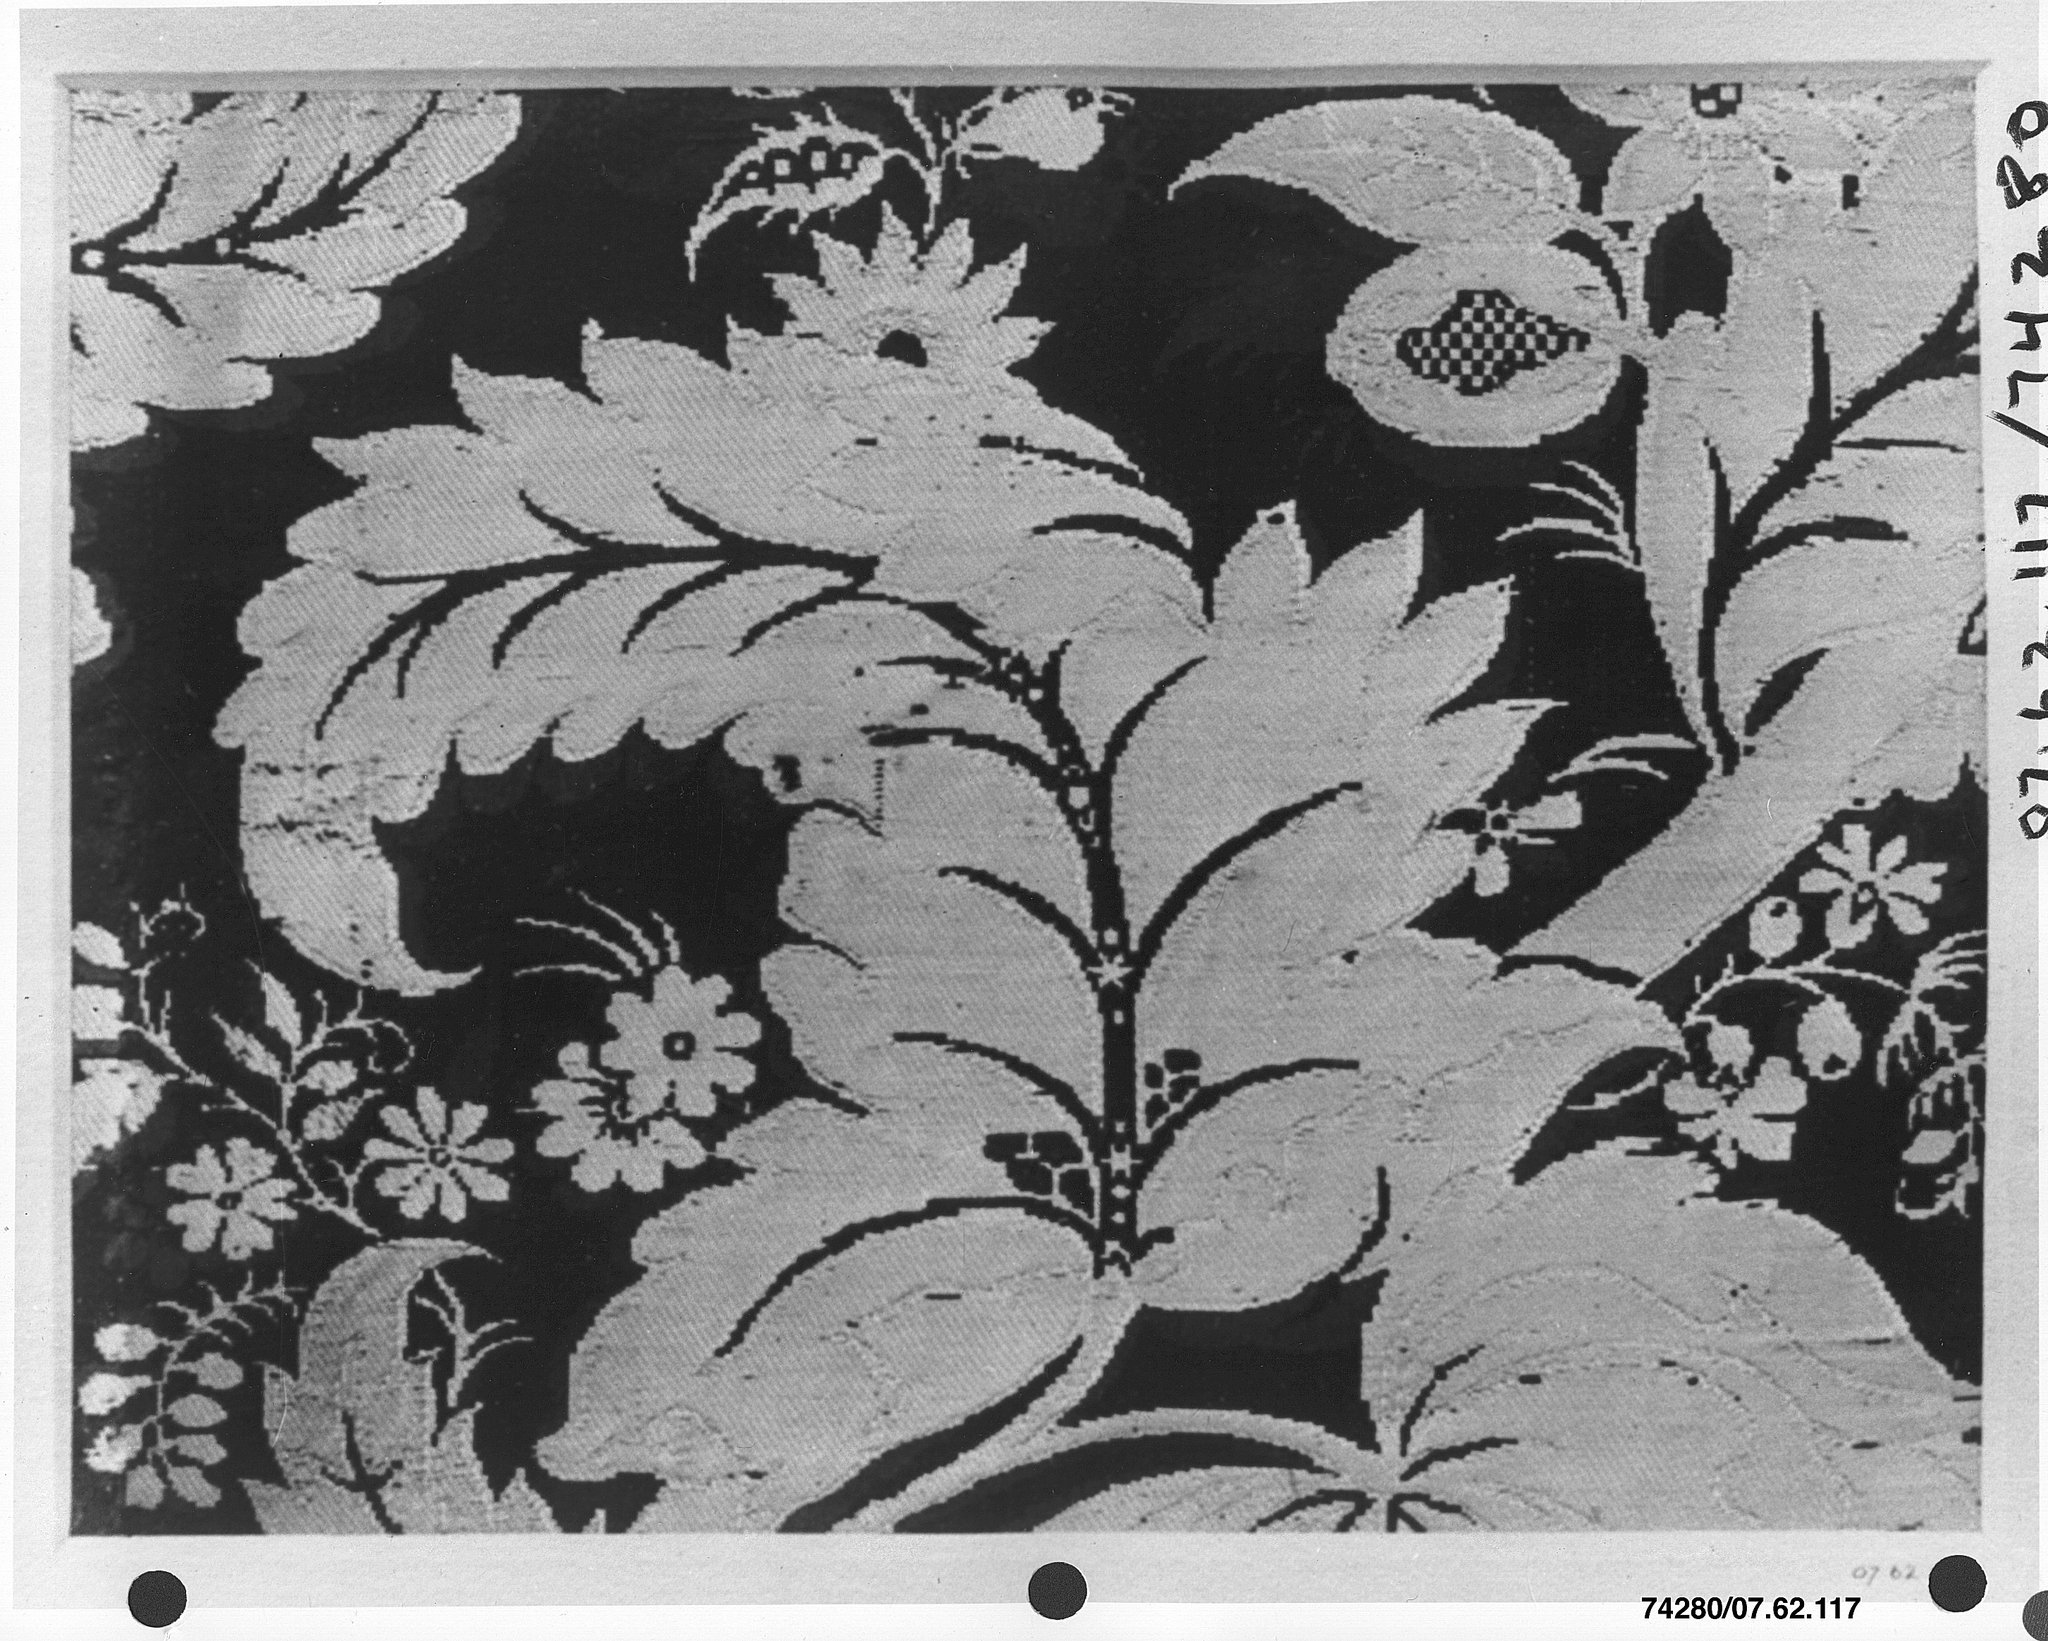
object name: piece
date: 1725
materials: silk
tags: flowers,leaves